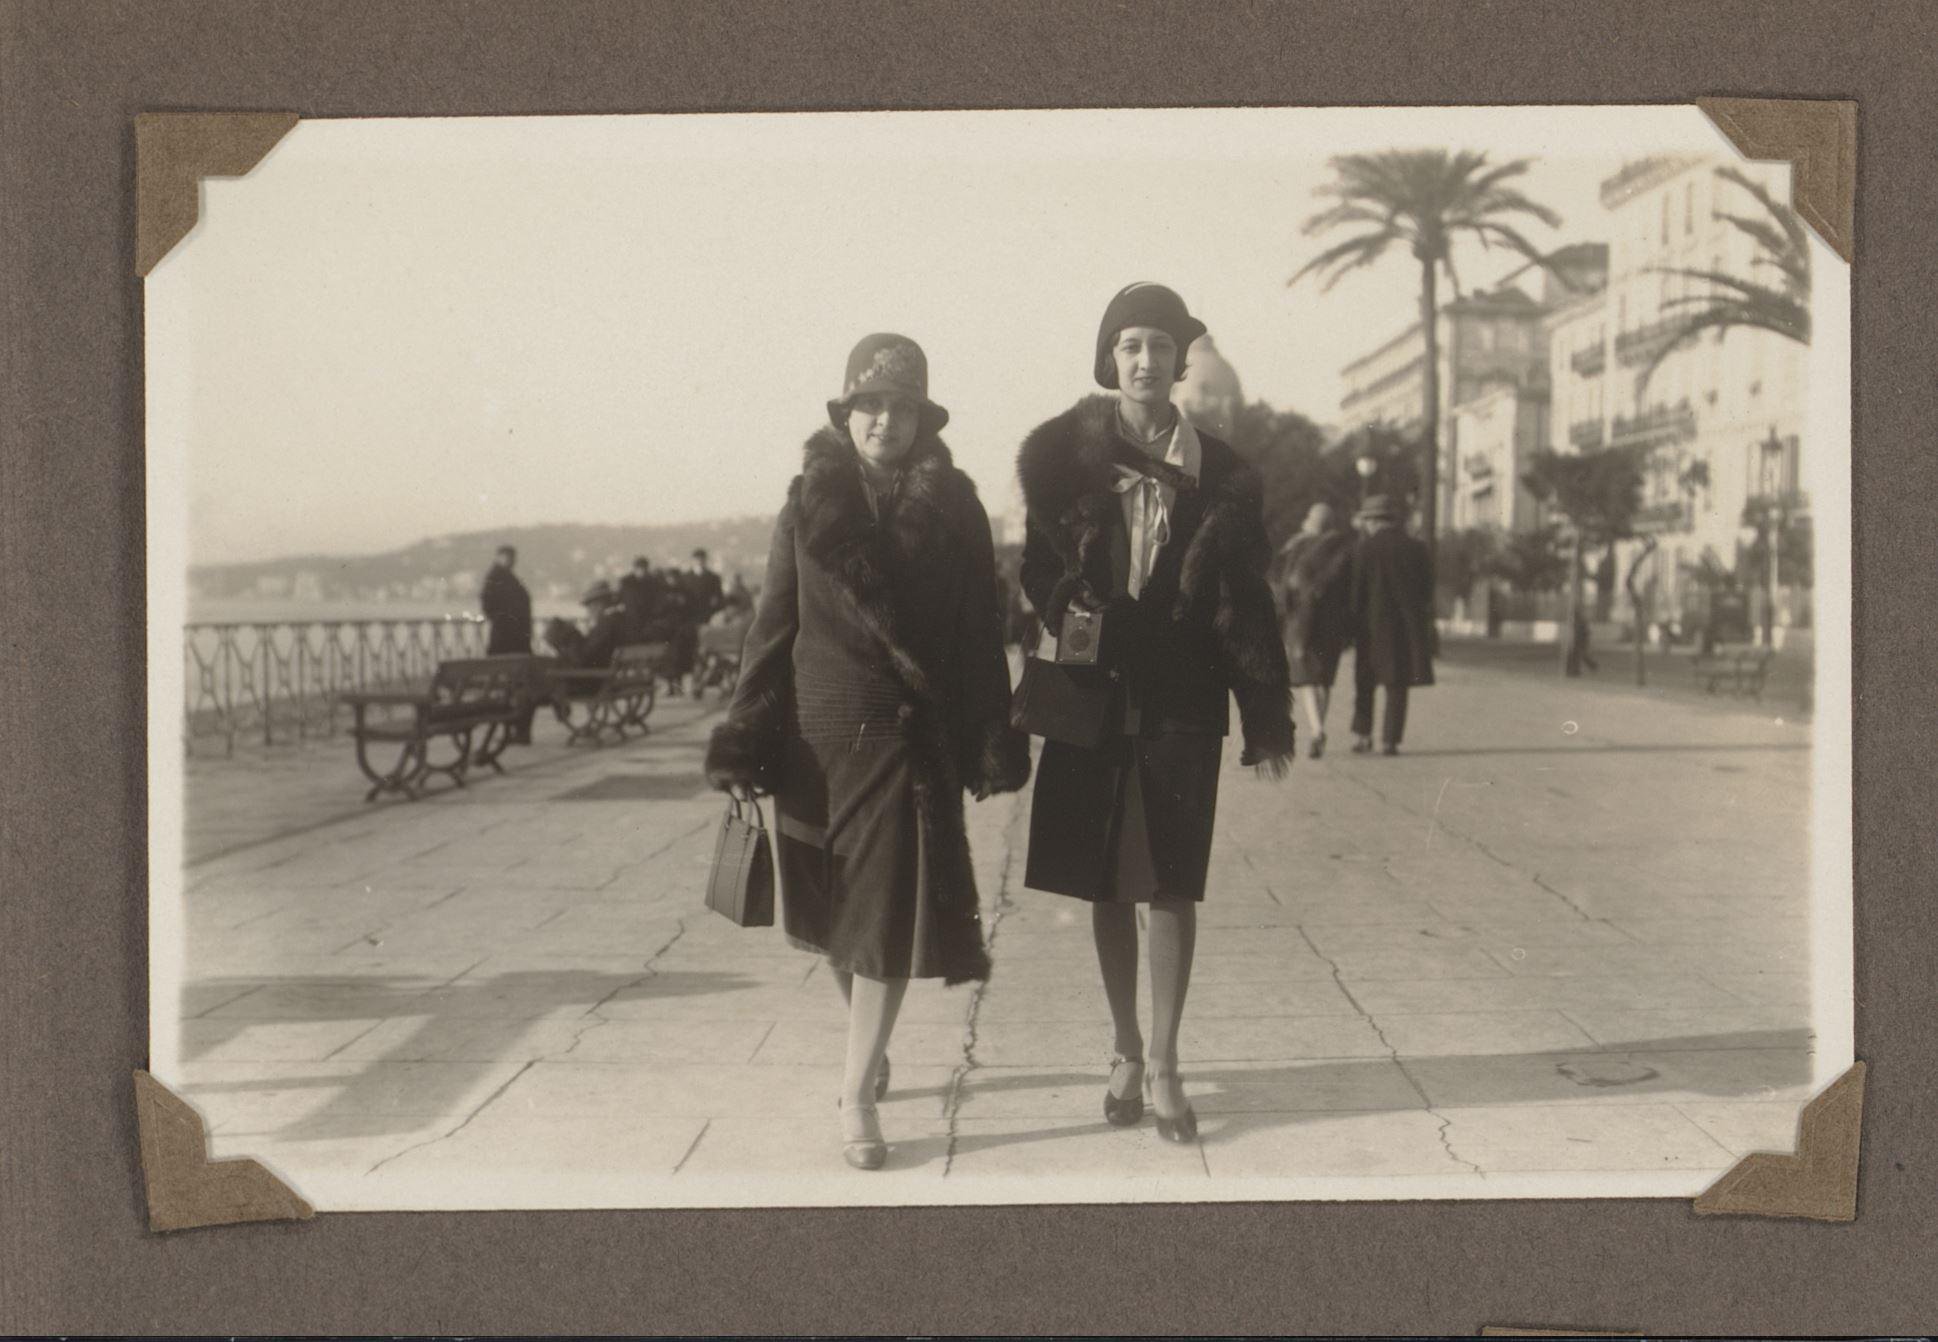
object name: album leaf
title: Portret van Henriëtte Wassink en Dootje van Zijll de Jong lopend over een boulevard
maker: Anonymous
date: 1930-1935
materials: paper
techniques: gelatin silver print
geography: nice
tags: batavia, the hague, henriëtte wassink, historical persons - bb - woman, strolling, avenue, boulevard, promenade, esplanade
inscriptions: inscription: ‘Carte Postale/ Correspondance P Adresse’